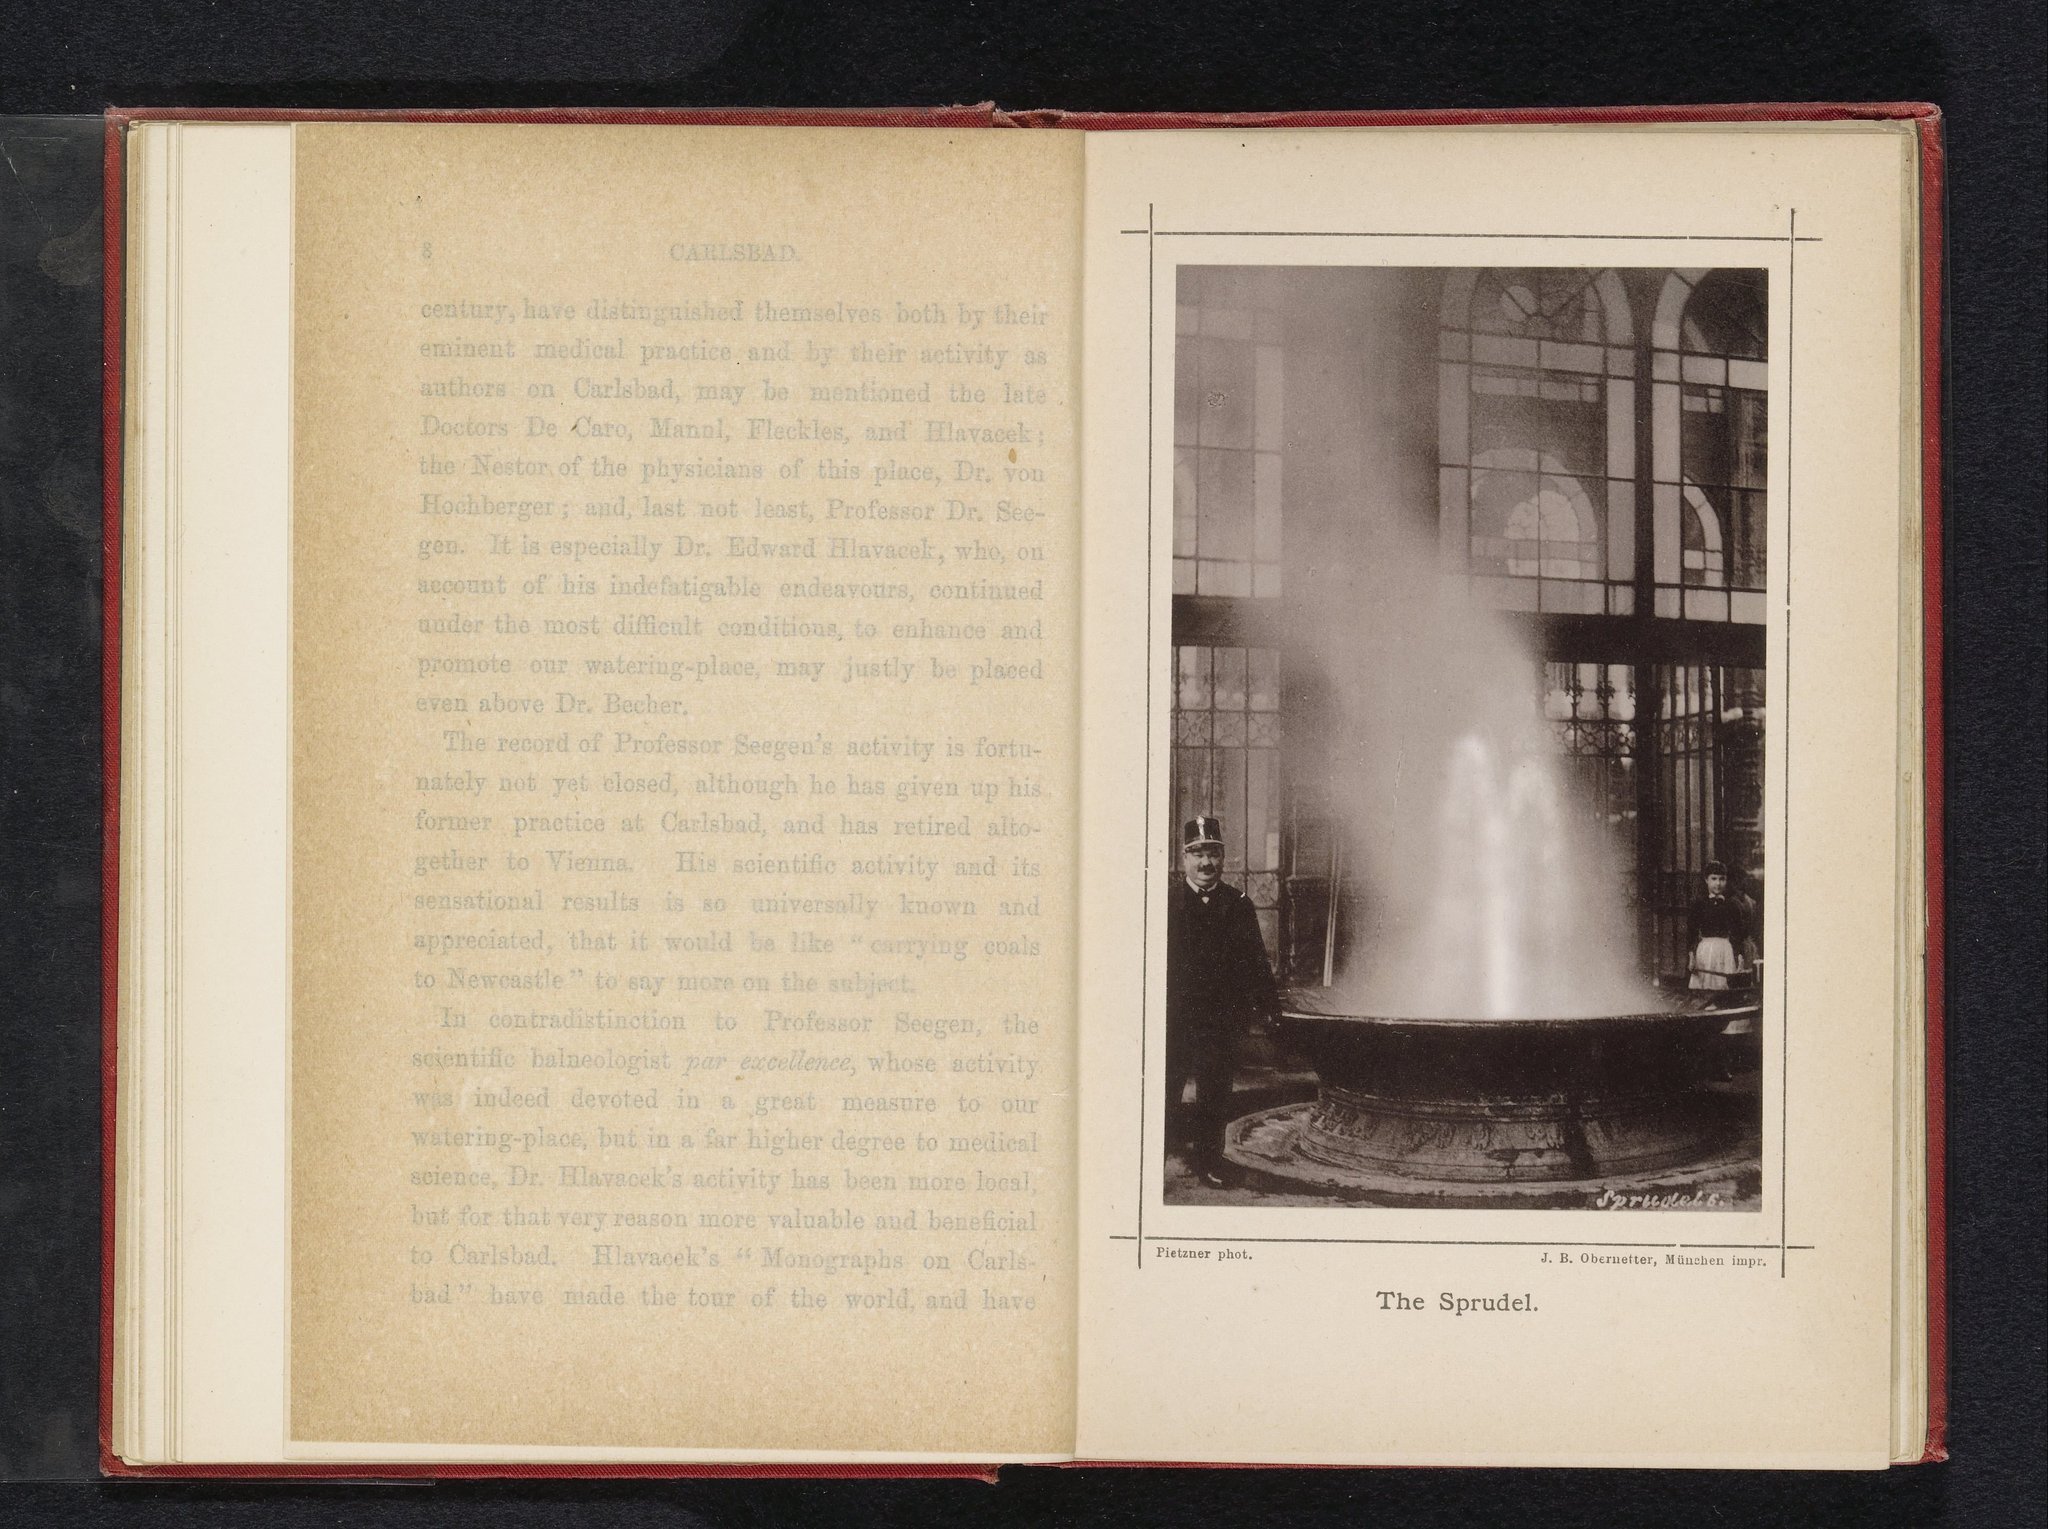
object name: page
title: Thermale bron bij het kuuroord in Karlovy Vary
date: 1881-1891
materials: paper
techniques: photograph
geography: munich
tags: hot spring, geyser, watering-place, spa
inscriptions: inscription: ‘Sprudel 6.’